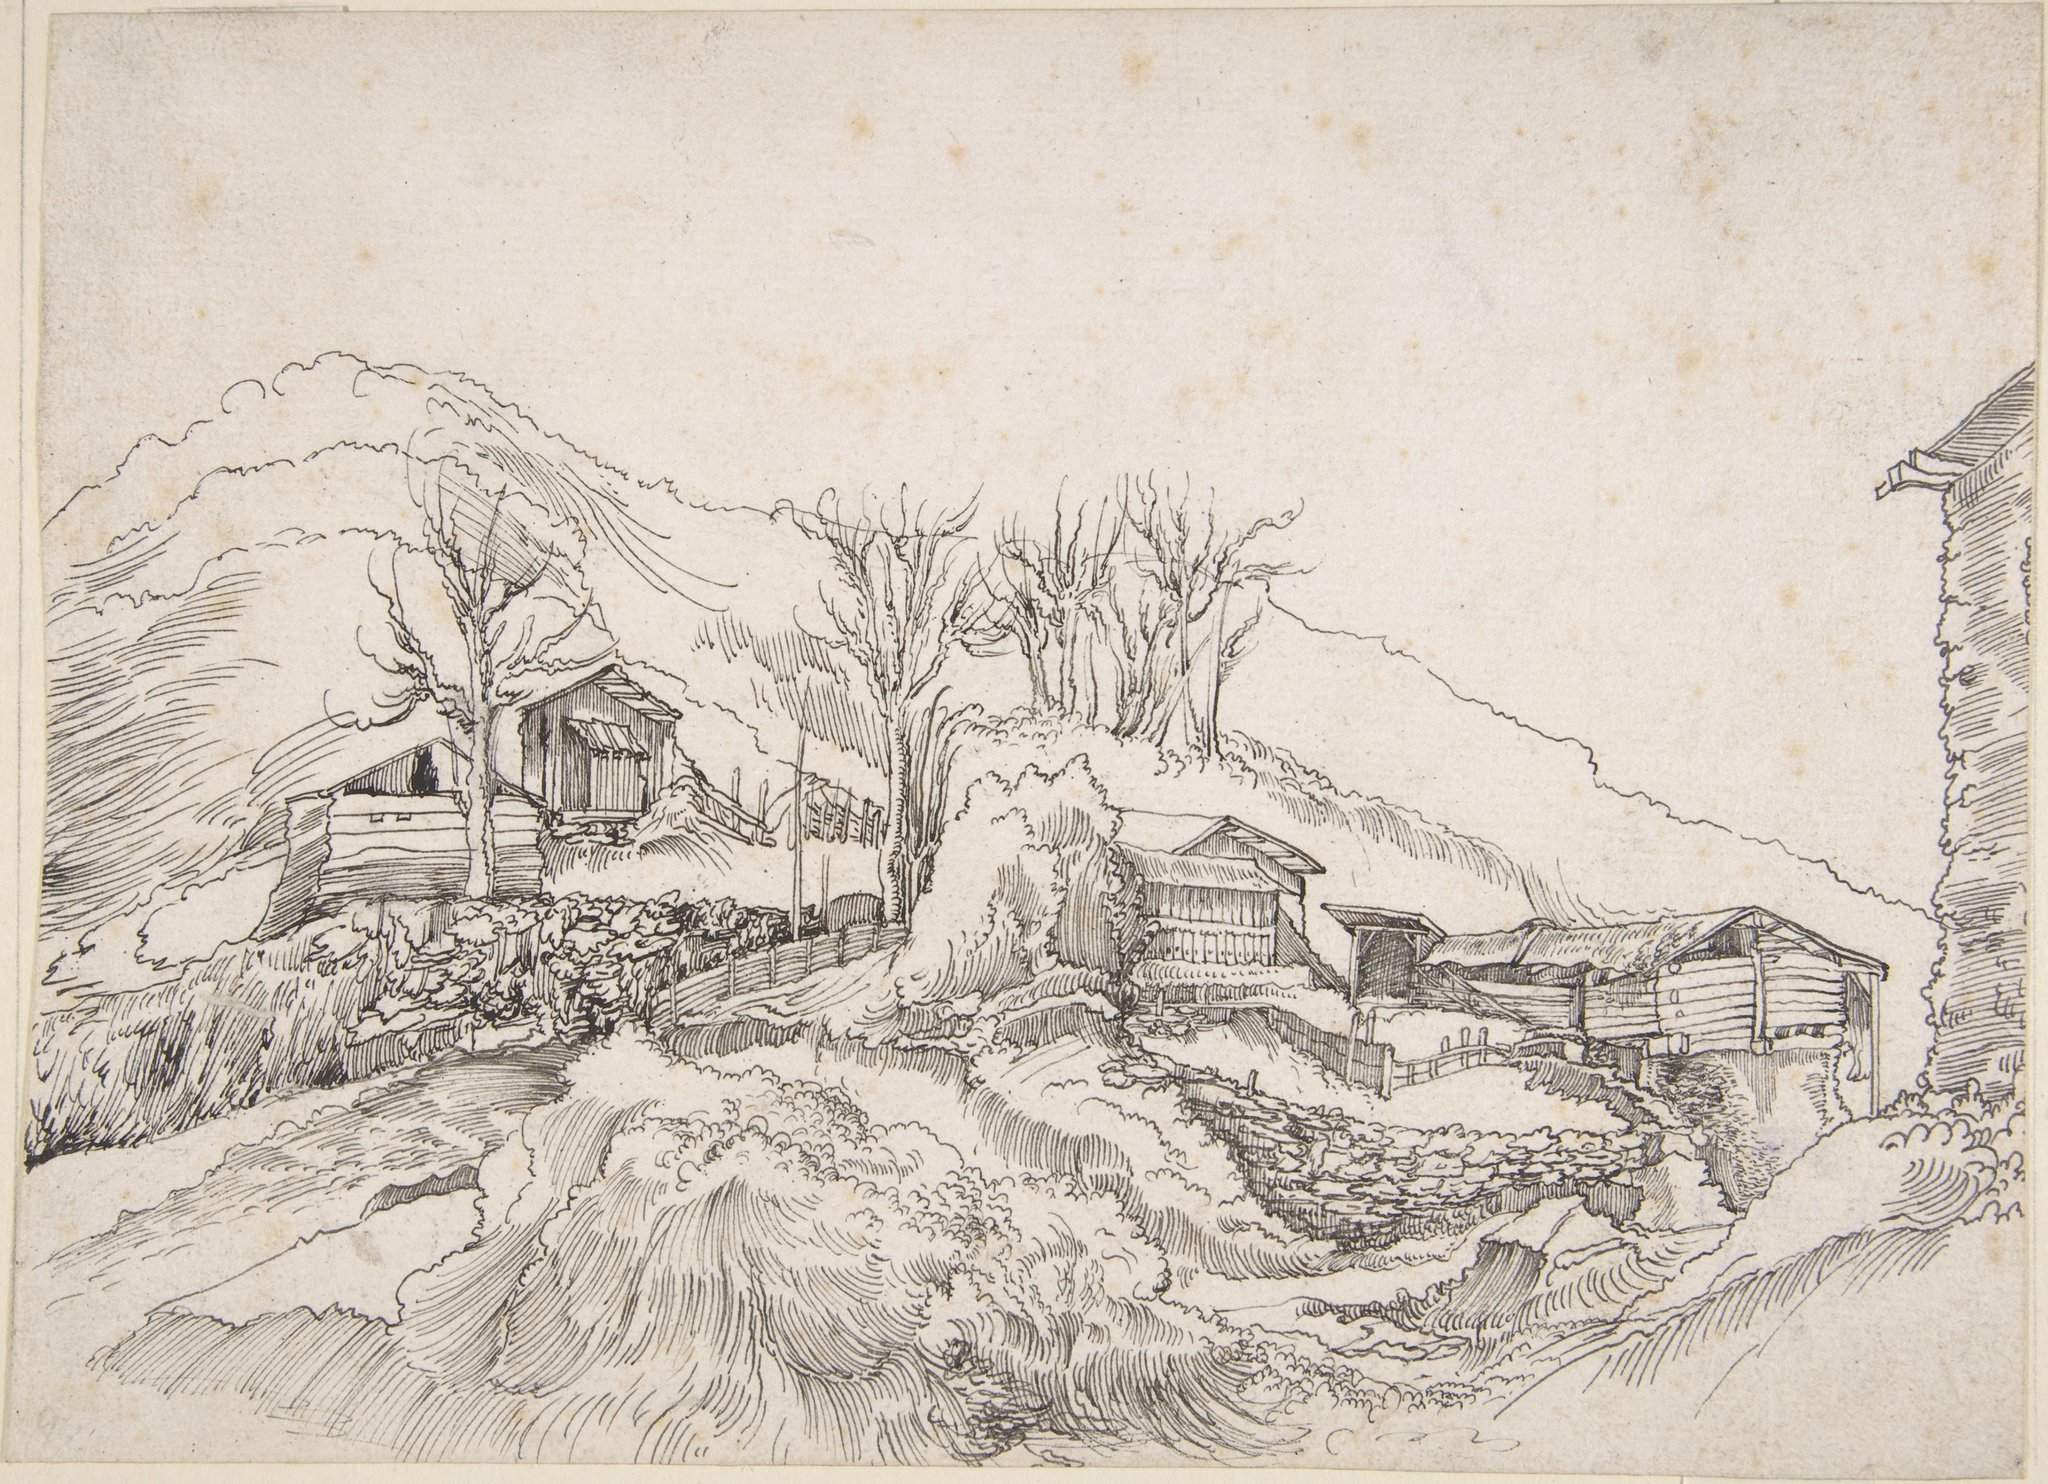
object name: drawing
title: Cottages in a Rocky Landscape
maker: wolfgang huber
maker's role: draughtsman, print maker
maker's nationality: german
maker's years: 1490-1553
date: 1501-1600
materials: ink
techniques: pen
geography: germany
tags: landscapes